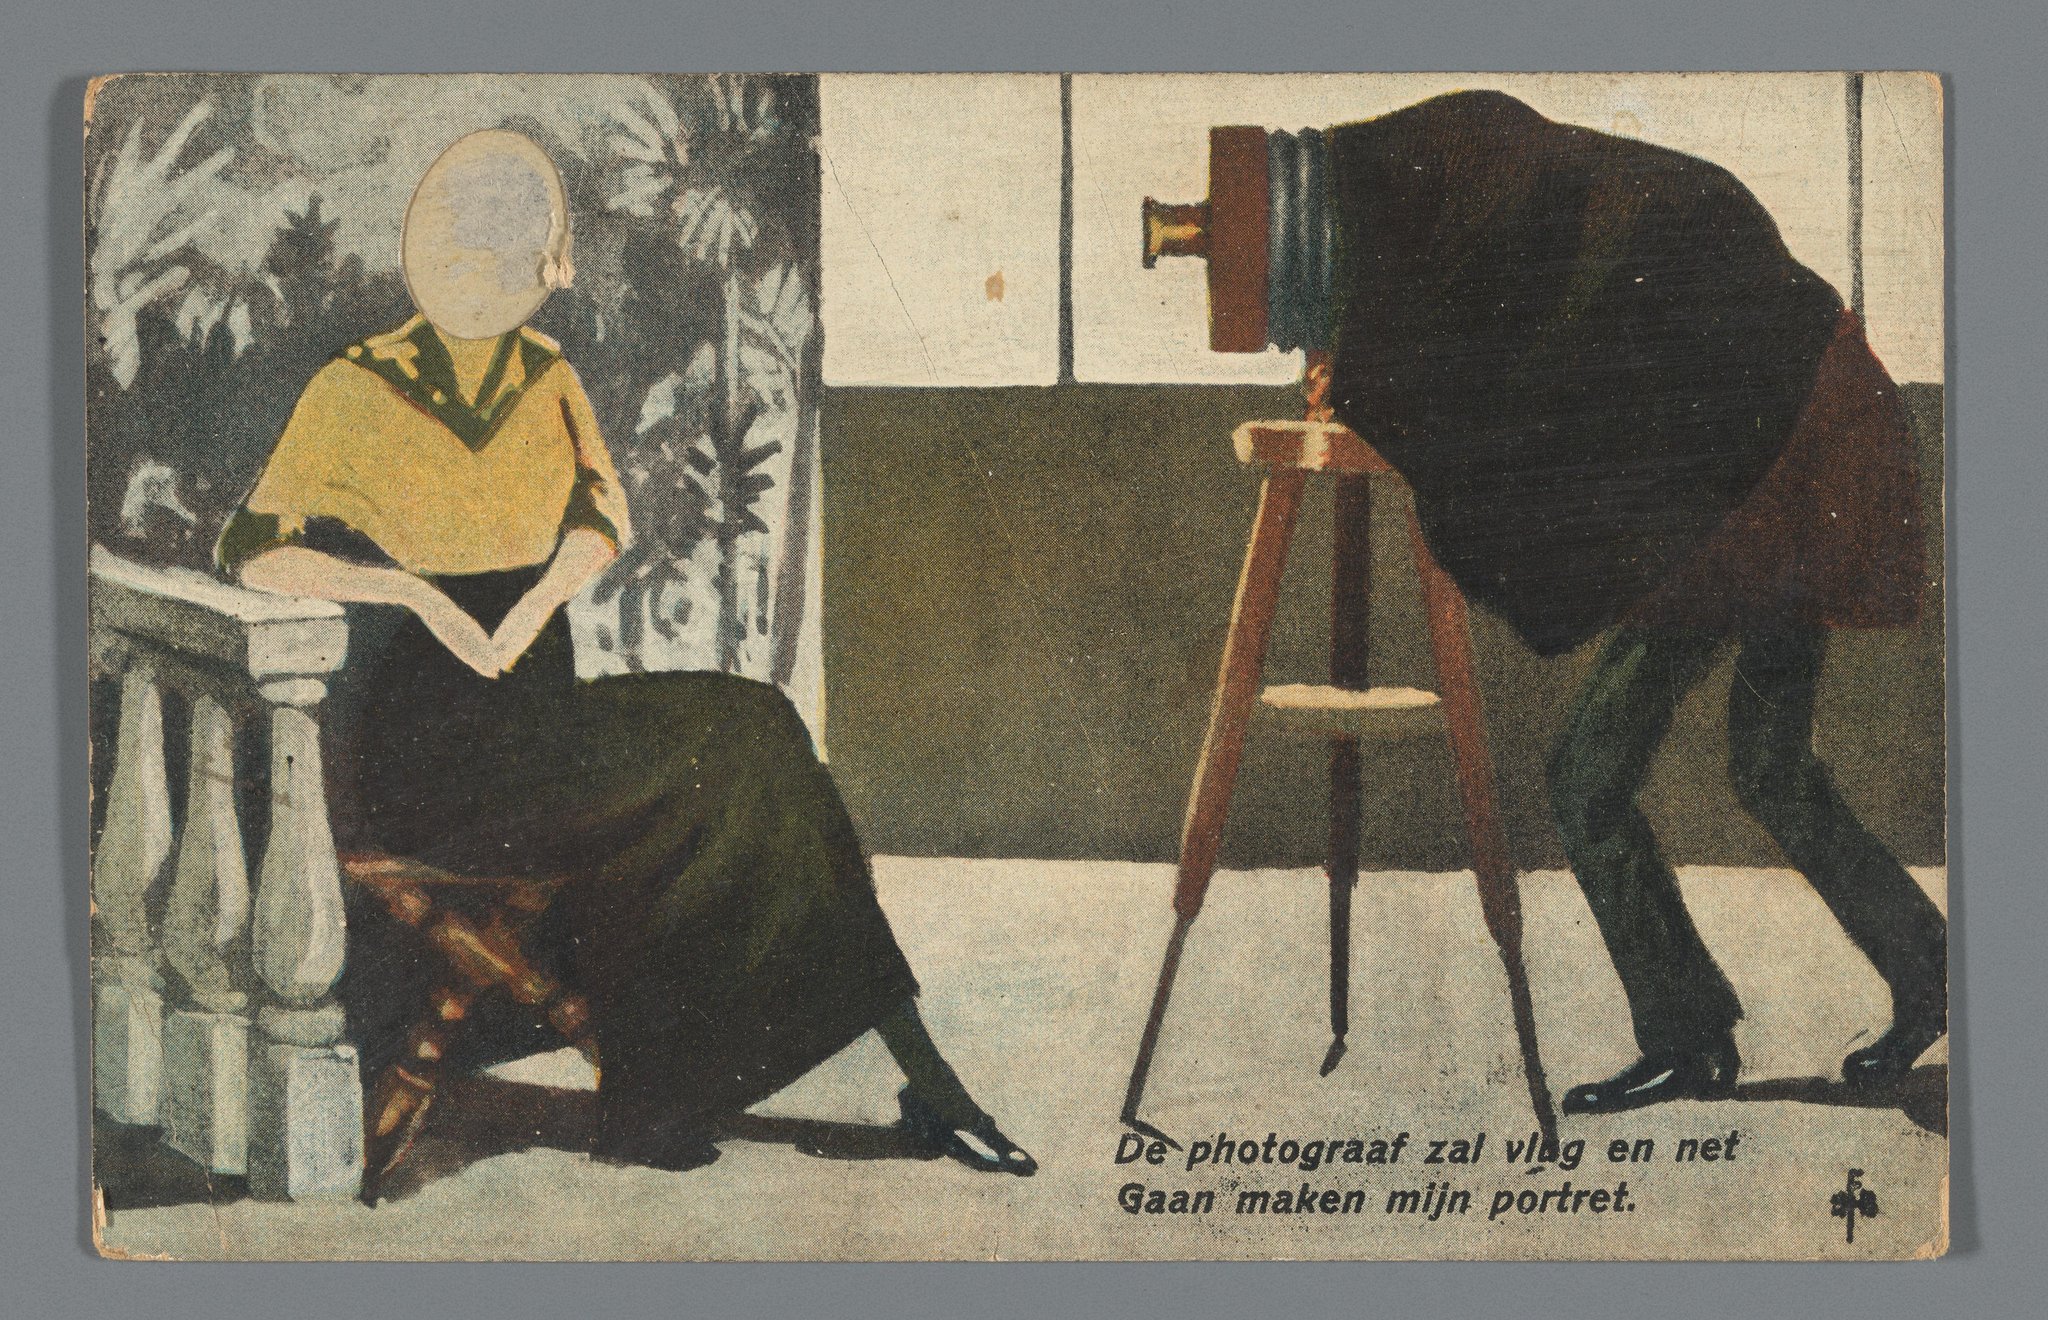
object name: ansichtkaart, prentbriefkaart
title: Fotograaf neemt een portret van een vrouw met inwisselbaar gezicht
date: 1905-1930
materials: cardboard, paper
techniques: cutting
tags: taking photographs of model, sitter, camera ~ photography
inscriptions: inscription: ‘De photograaf zal vlug en net/ Gaan maken mijn portret.’, copyright notice: ‘A.V.A. No. 3’